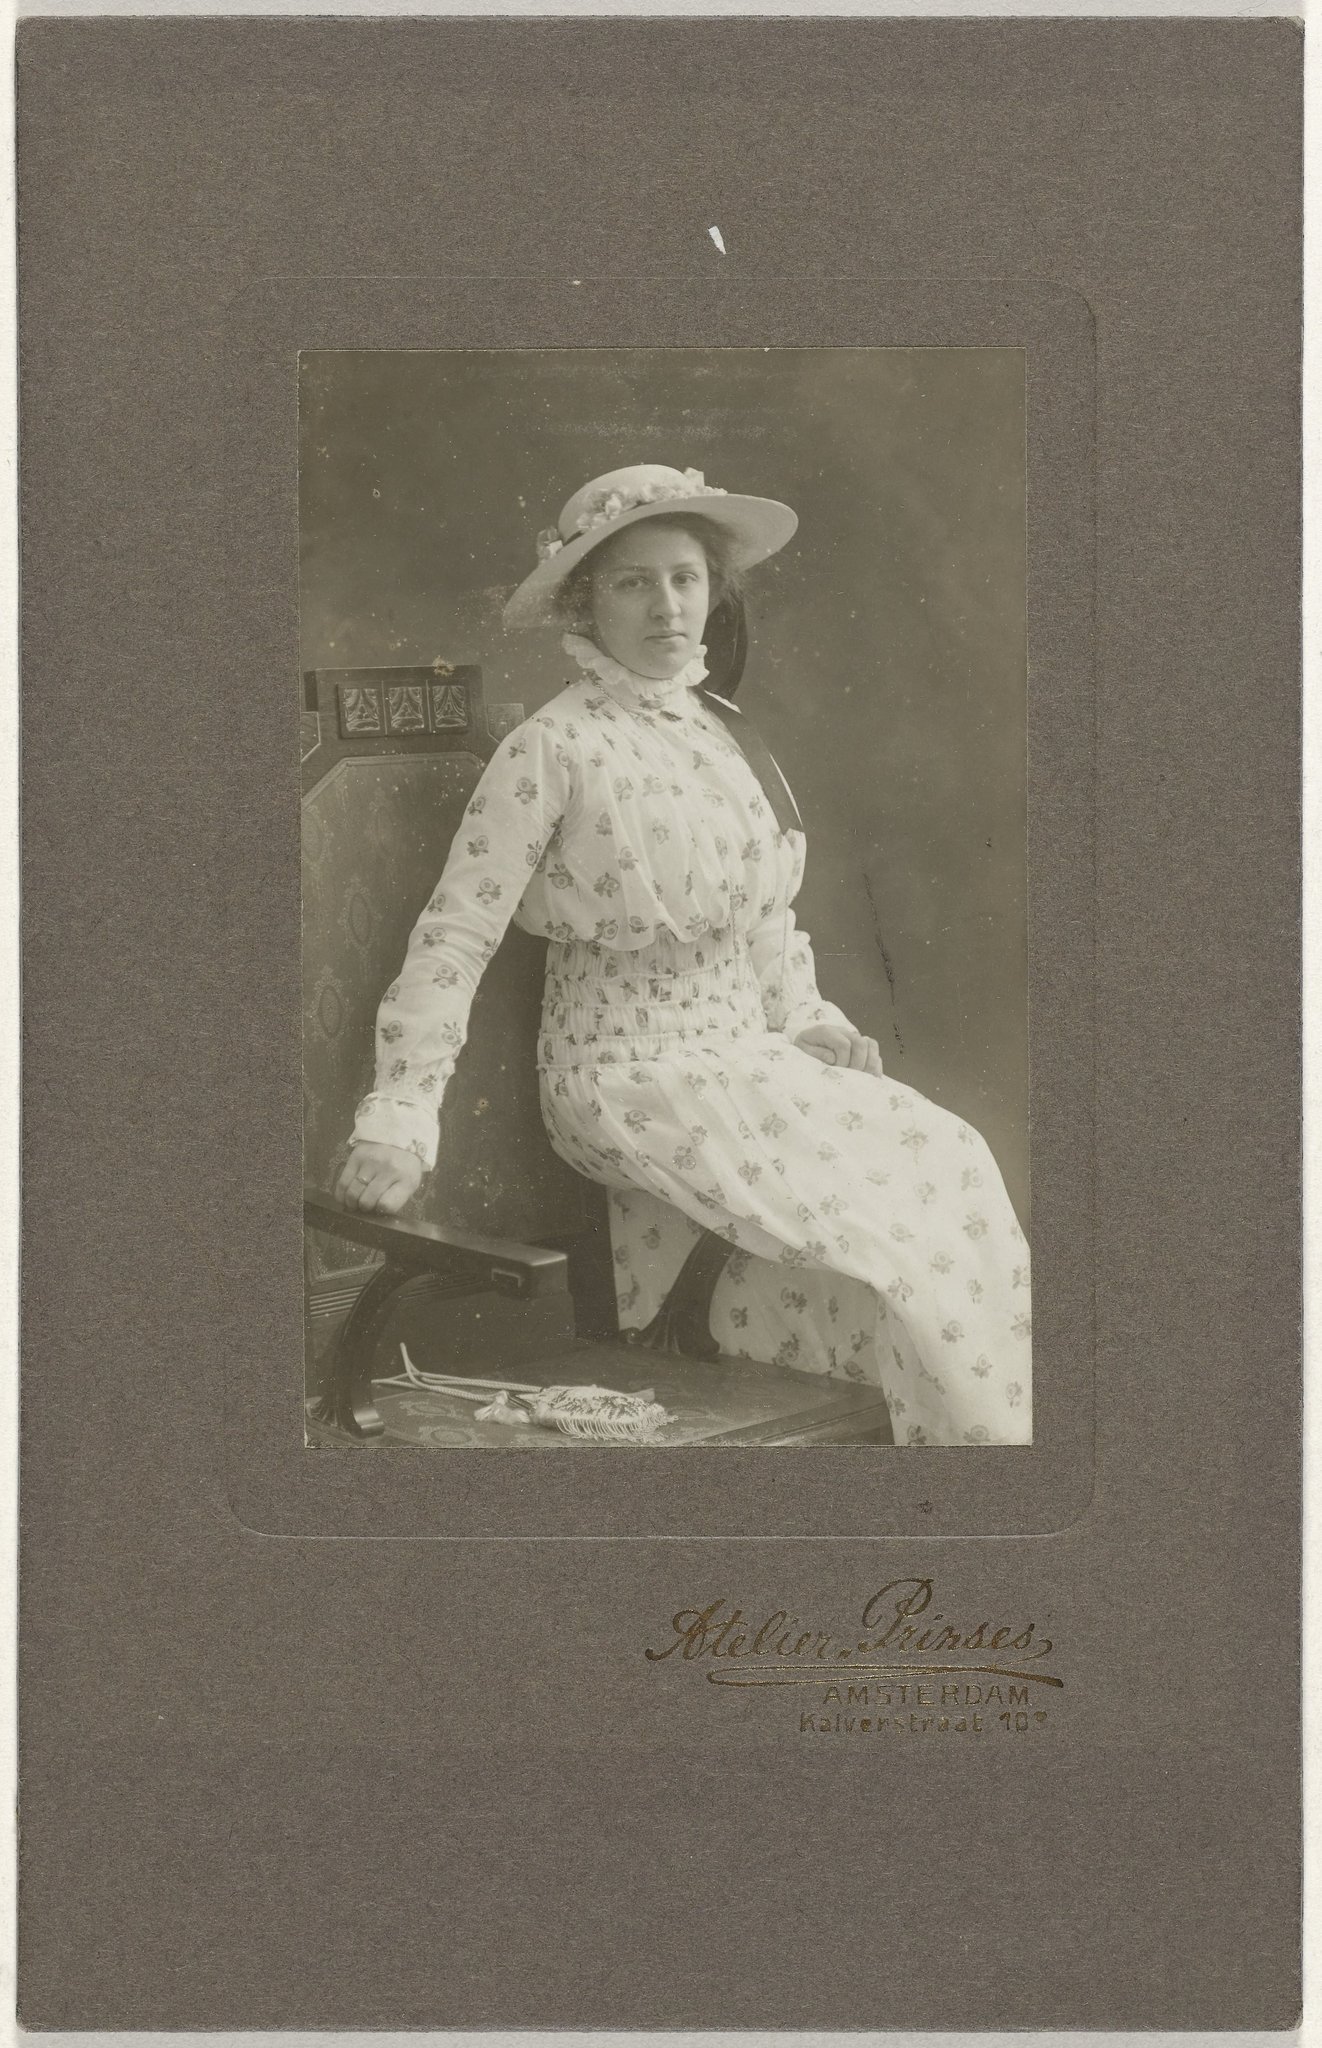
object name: cabinet photograph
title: Studioportret van een jongevrouw zittend op de leuning van een stoel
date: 1890-1925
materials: cardboard, photographic support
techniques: collodion silver print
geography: amsterdam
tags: amsterdam